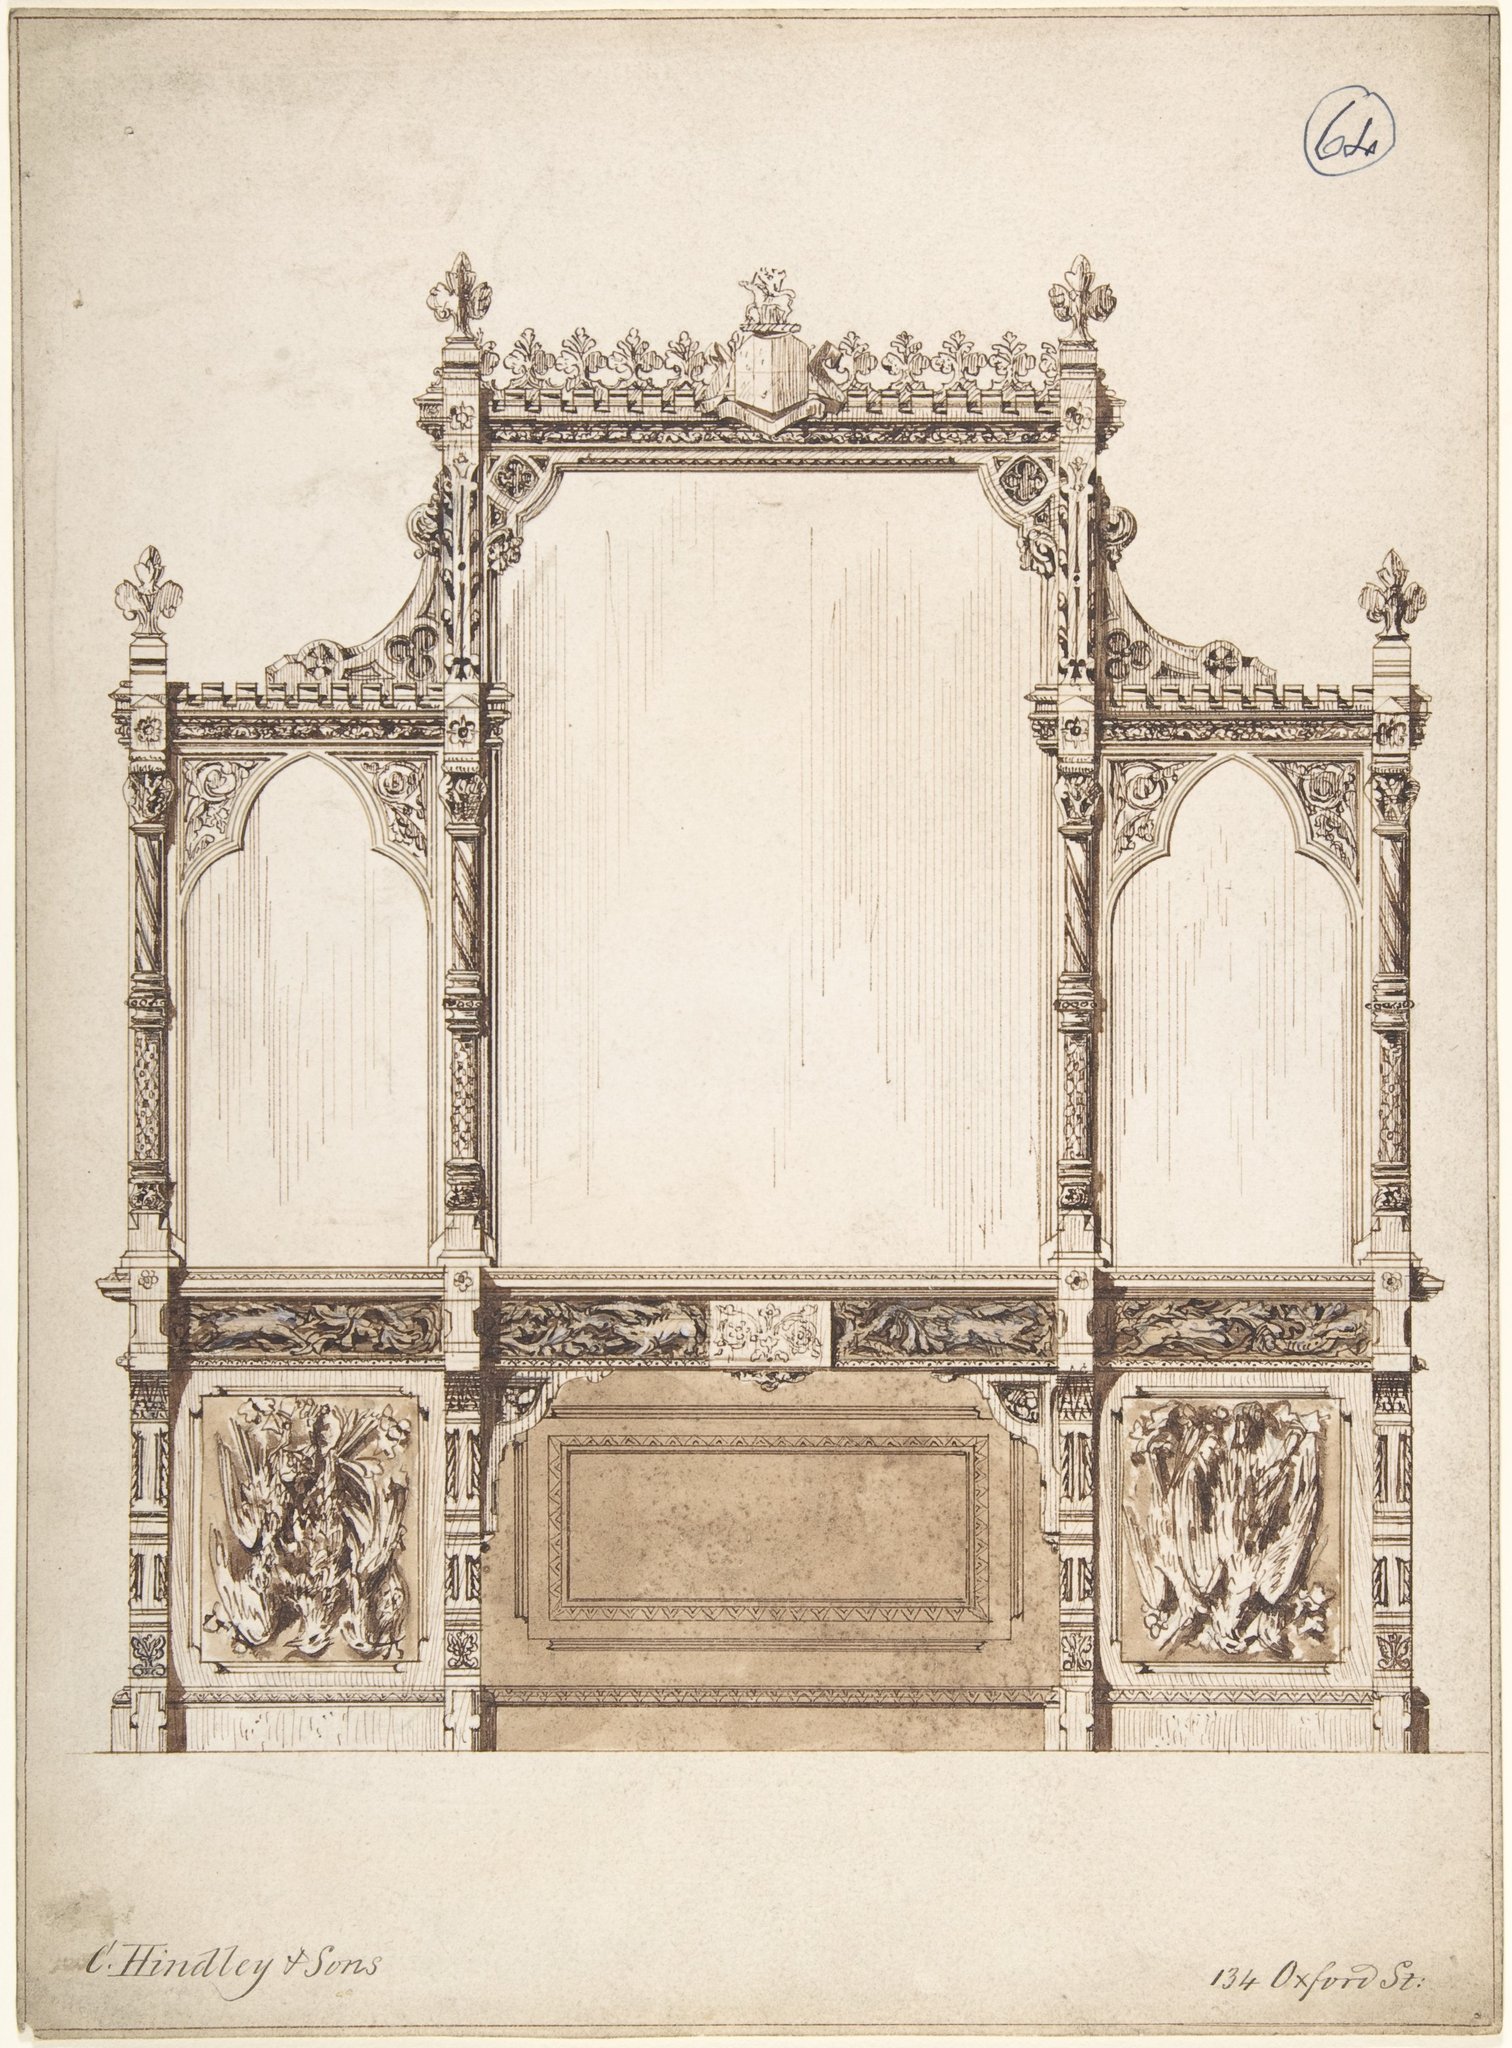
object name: drawing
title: Design for Wall with Wooden Trim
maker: charles hindley and sons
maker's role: artist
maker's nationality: british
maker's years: 1841-1917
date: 1841-1884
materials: ink, watercolor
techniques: pen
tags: architecture